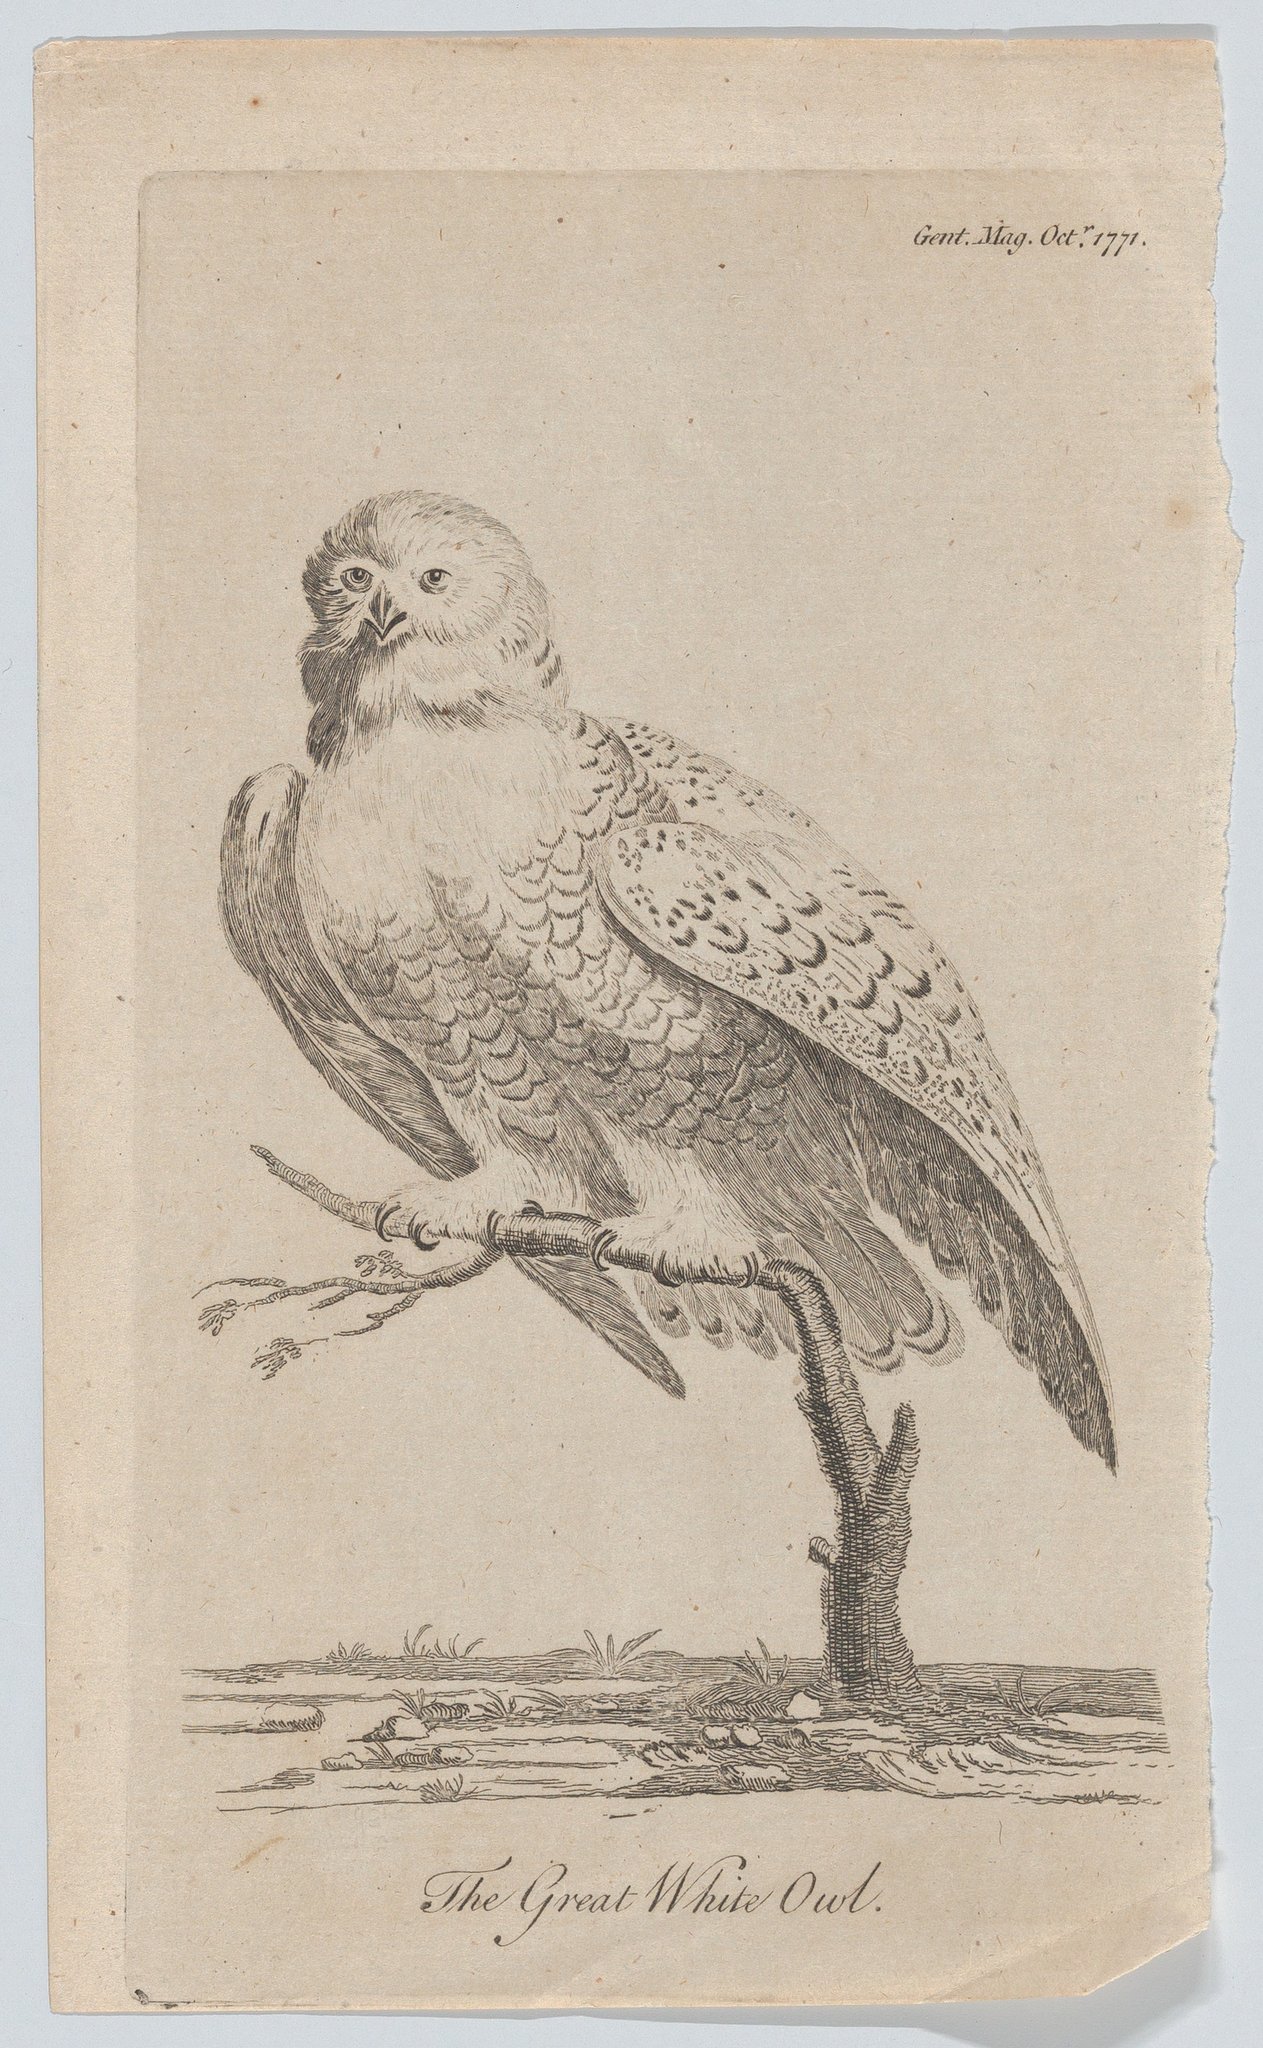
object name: print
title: The Great White Owl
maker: anonymous, british, 18th century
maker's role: artist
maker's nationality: british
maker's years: 1700-1800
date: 1771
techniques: engraving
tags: owls